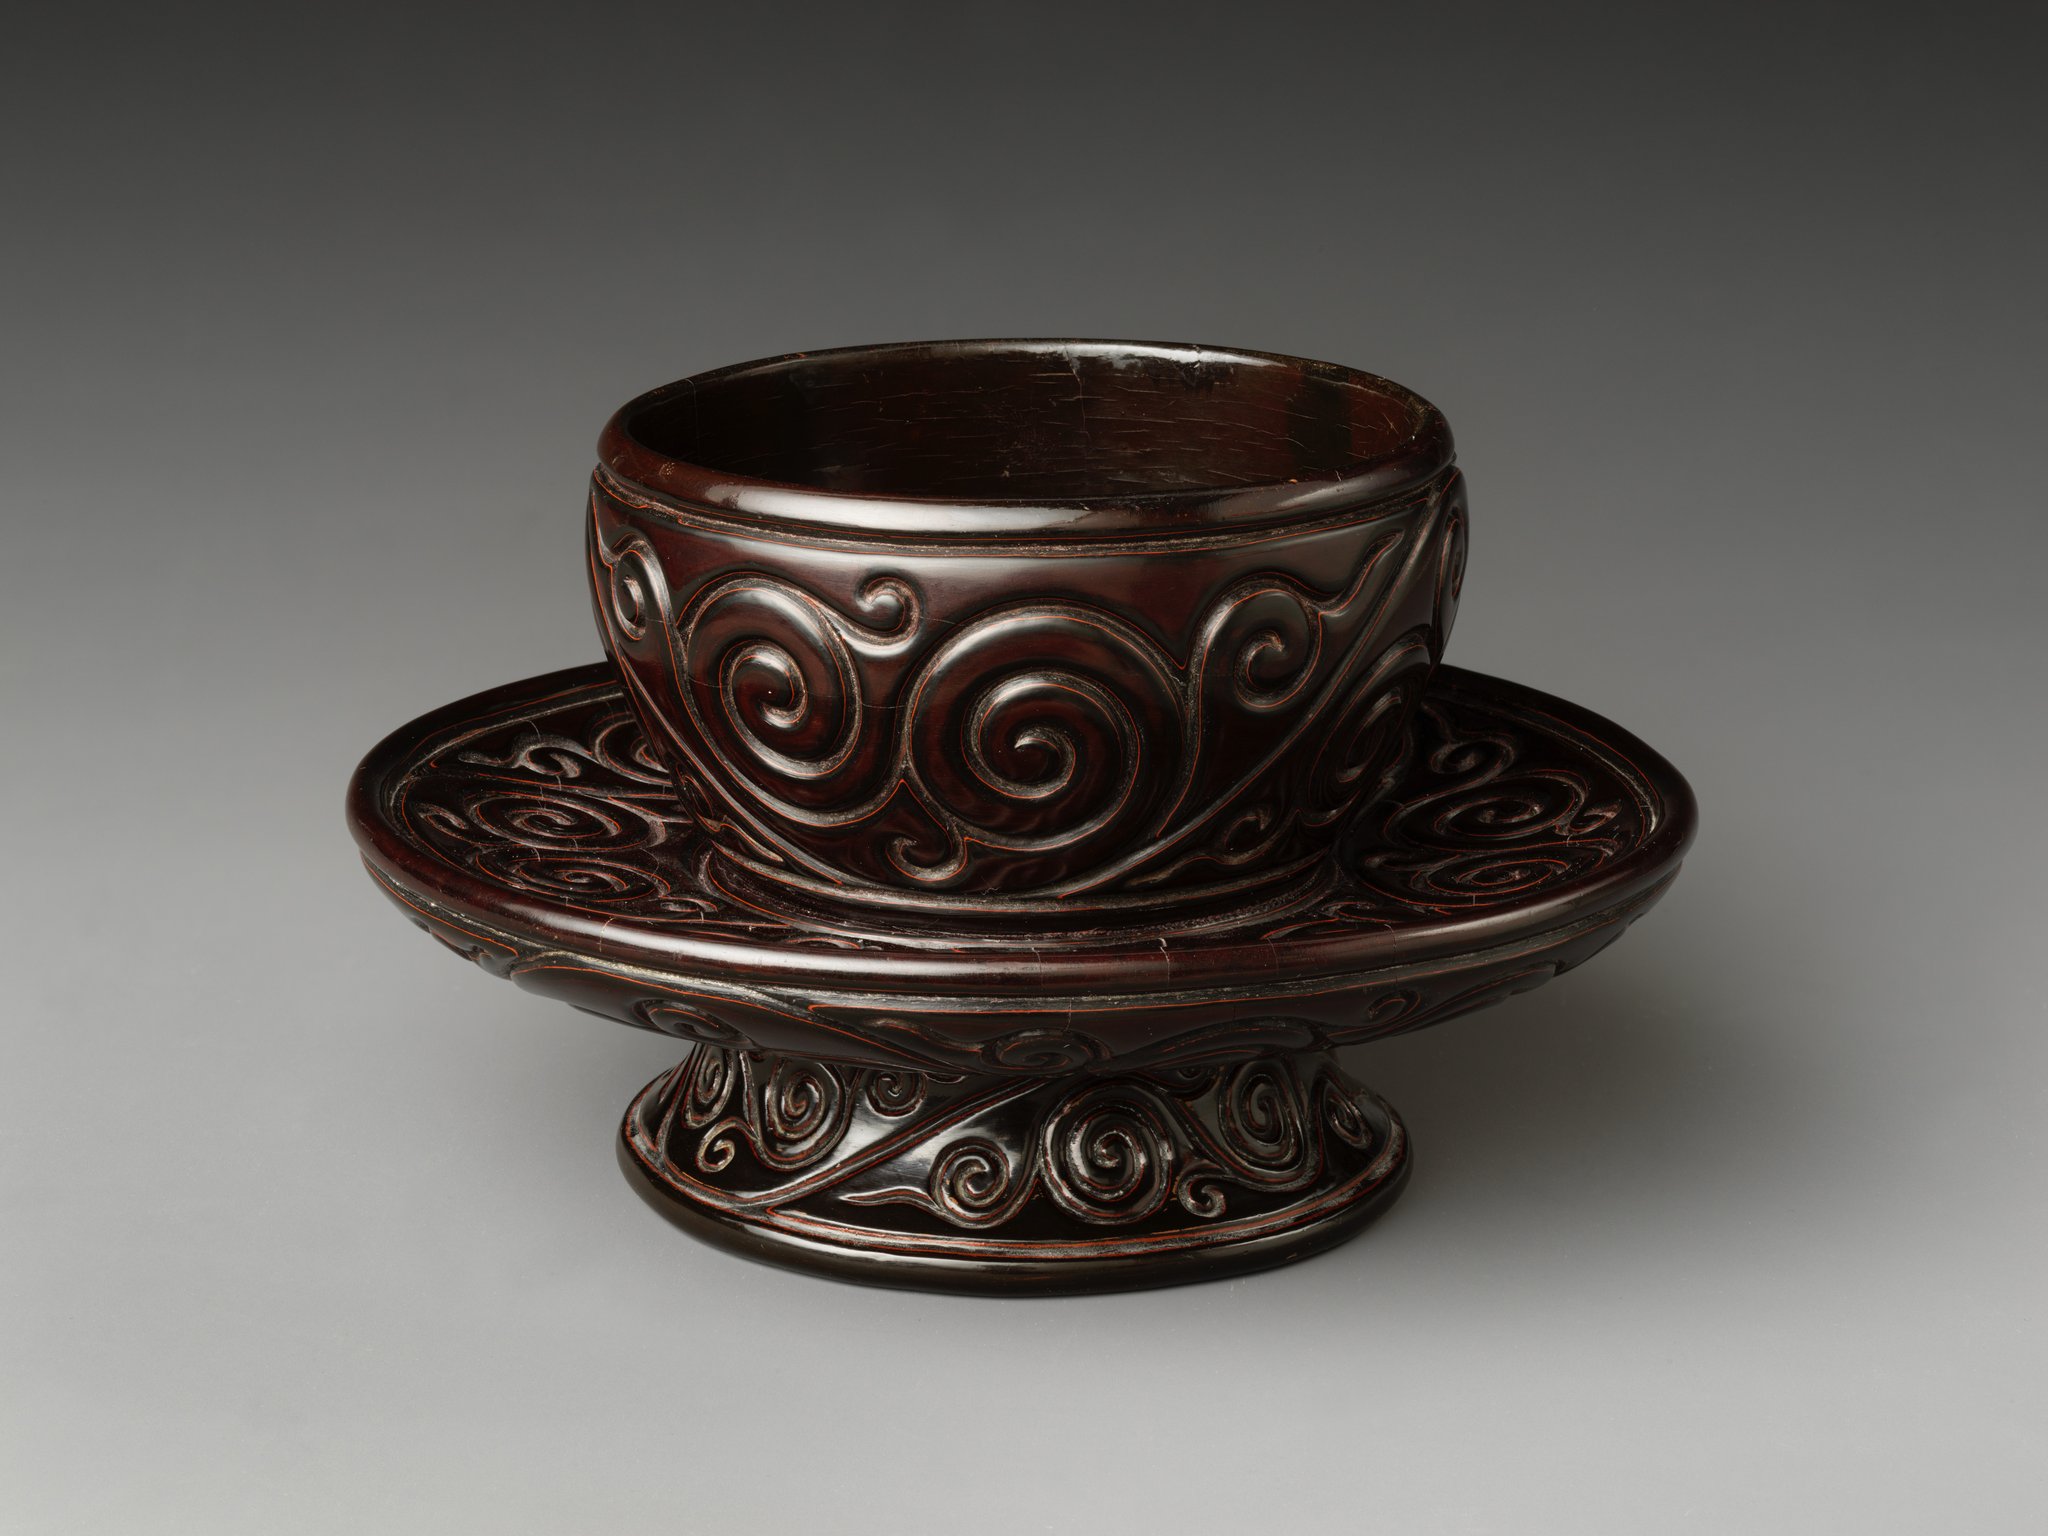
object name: tea bowl stand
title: Tea-bowl stand with pommel scrolls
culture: chinese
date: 1401-1500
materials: lacquer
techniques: carving